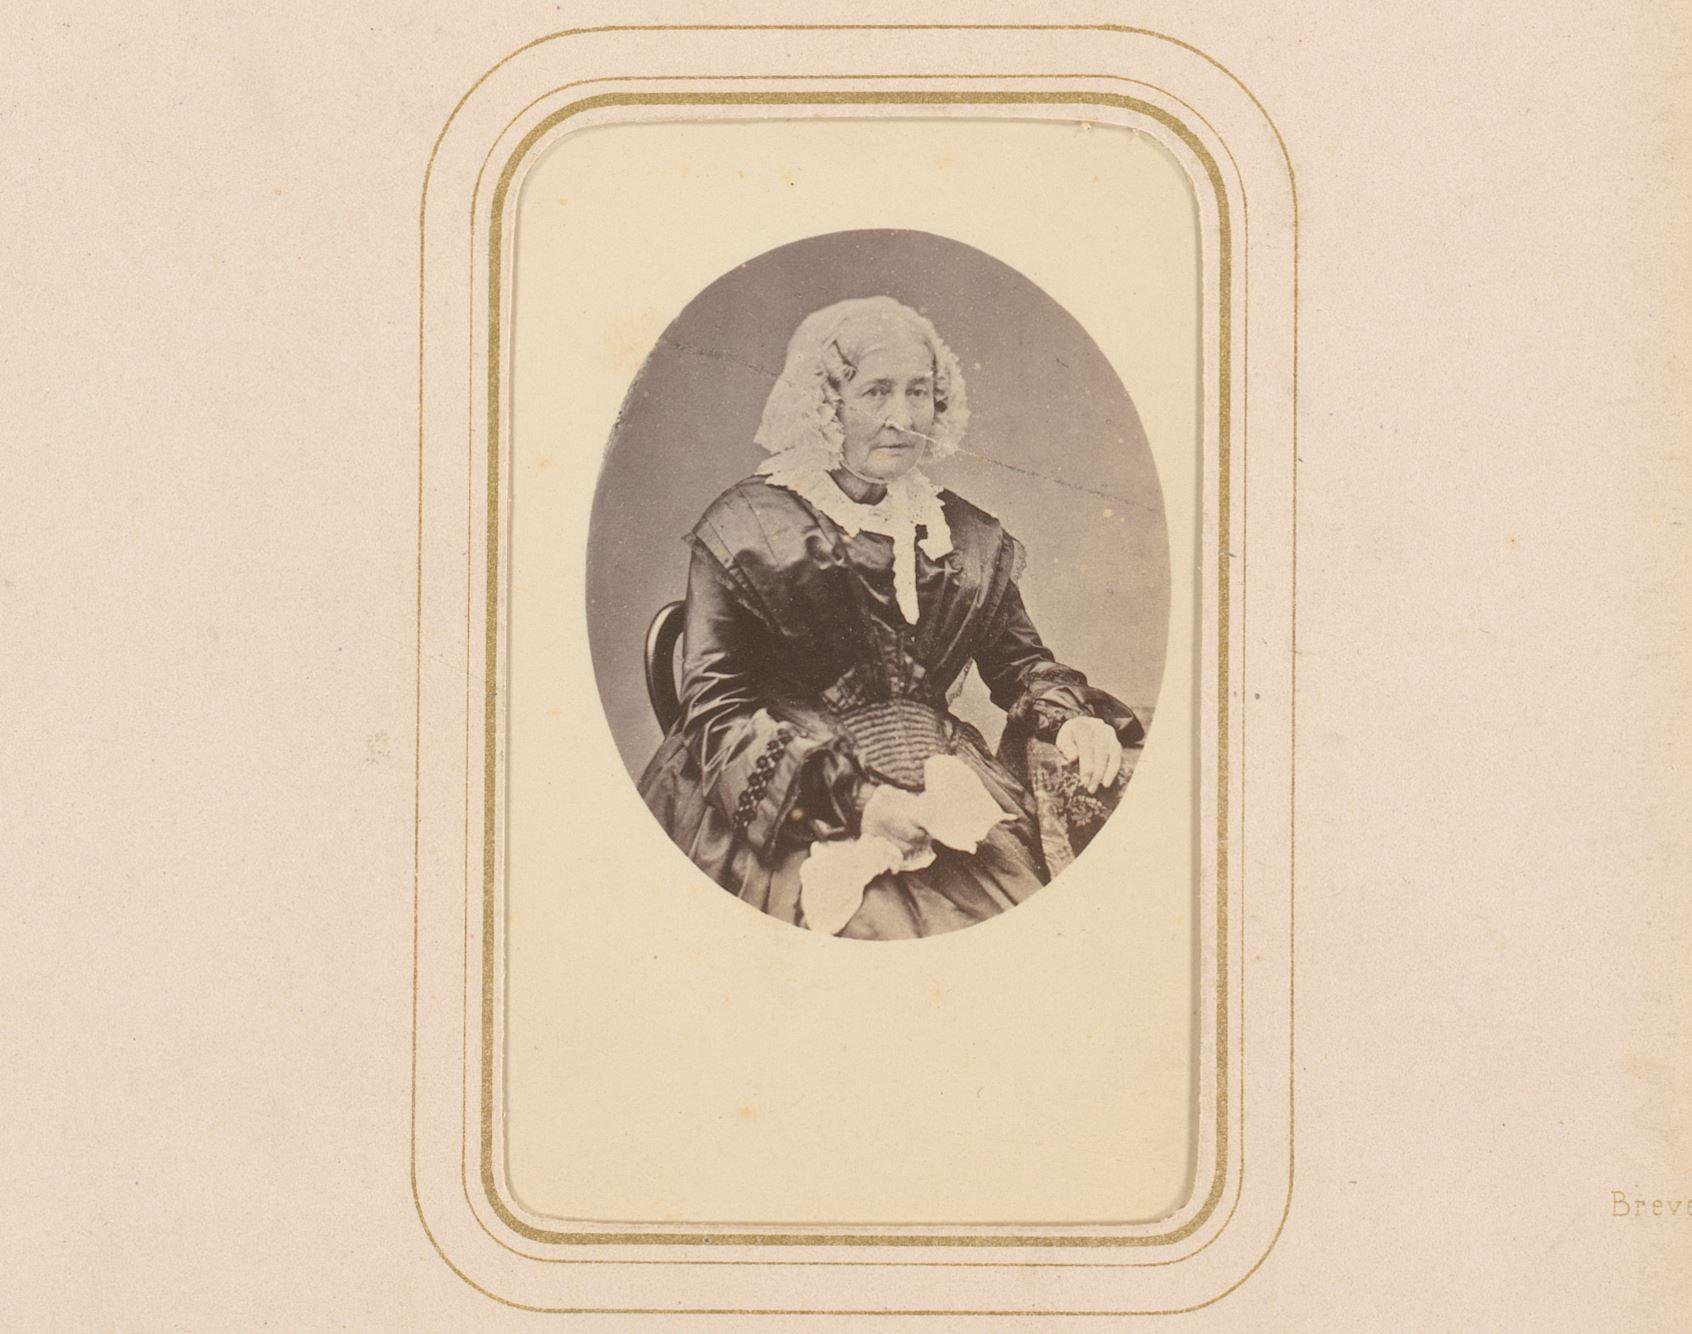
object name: carte de visite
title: Portret van een zittende vrouw met witte muts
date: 1860-1880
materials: cardboard, photographic support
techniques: albumen print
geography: bath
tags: sitting figure - aa - female human figure, historical persons - bb - woman, head-gear: cap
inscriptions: inscription: ‘THEWENETI/ BROTHERS,/ 29, Henrietta Street,/ BATH./ Copies may be had at any time by Sending the Name.’